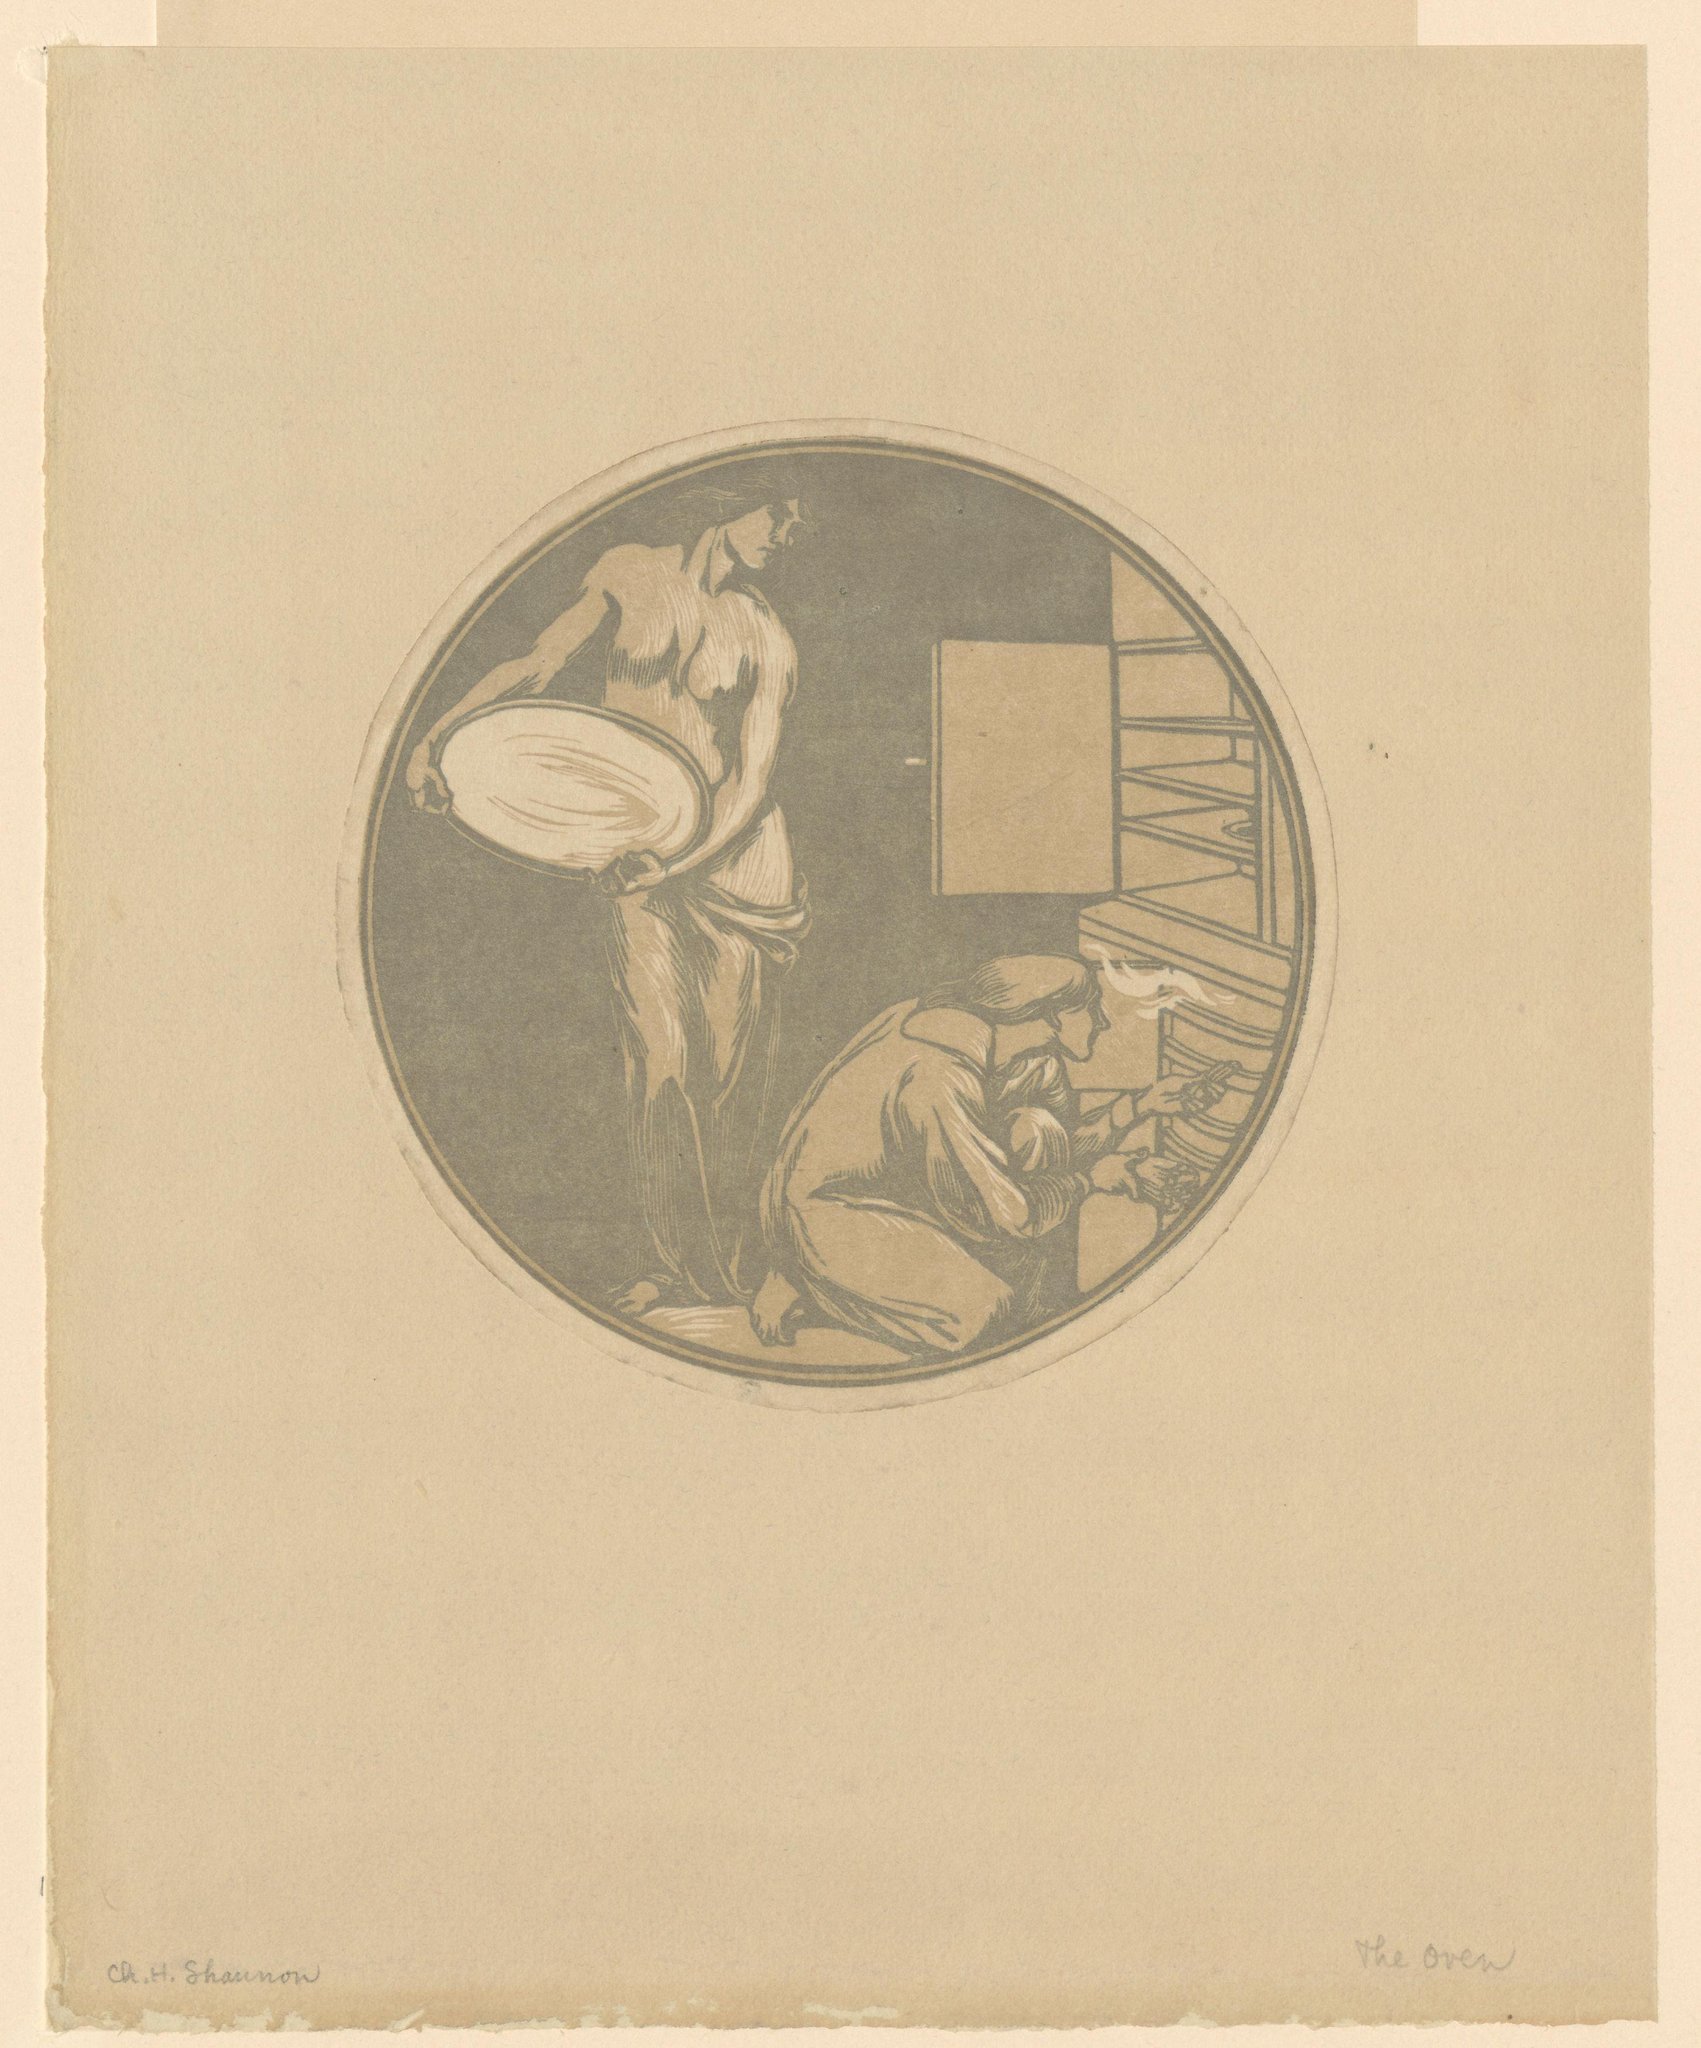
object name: print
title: The oven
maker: charles haslewood shannon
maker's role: draughtsman, print maker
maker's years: 1865-1937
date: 1898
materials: paper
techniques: woodcut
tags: oven ~ kitchen, dish, plate, saucer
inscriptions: collector's mark: ‘[al]bois 3714’, collector's mark: Lugt 2228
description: Prent maakt waarschijnlijk deel uit van een serie met twaalf voorstellingen. Over deze serie is verder niets bekend. Het betreft voornamelijk voorstellingen met betrekking tot de twaalf maanden van het jaar en oogsten.